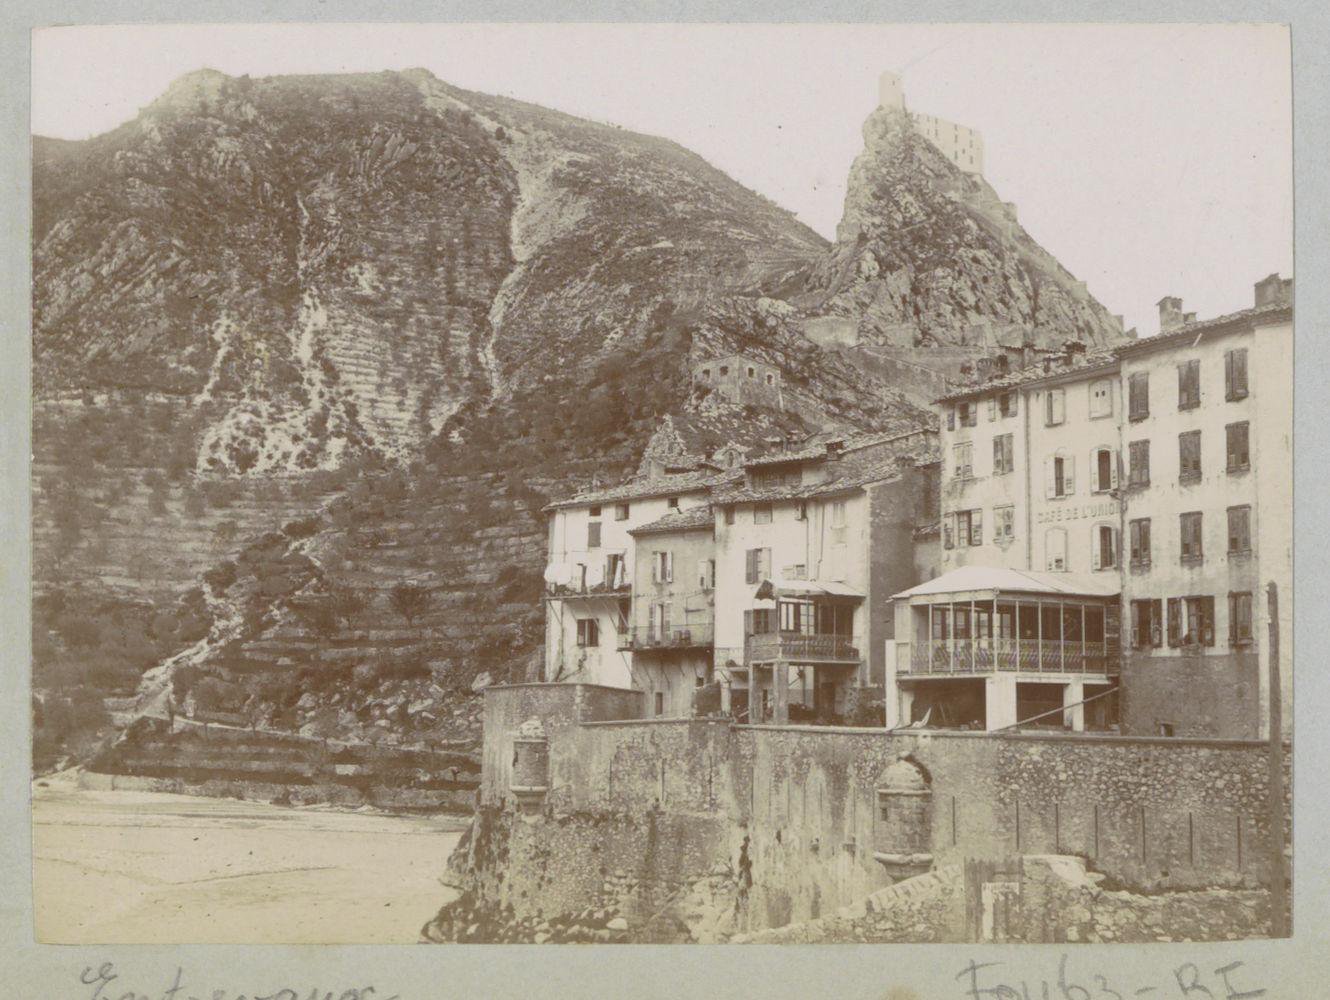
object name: photograph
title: Gezicht op het bergdorp Entrevaux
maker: delizy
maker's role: manufacturer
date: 1903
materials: paper, photographic support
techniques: gelatin silver print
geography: entrevaux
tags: prospect of village, silhouette of village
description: Onderdeel van Fotoalbum van een Franse amateurfotograaf met opnames van uitstapjes in Frankrijk, Spanje, België, Luxemburg en Nederland, de eerste automobielen en autoraces.